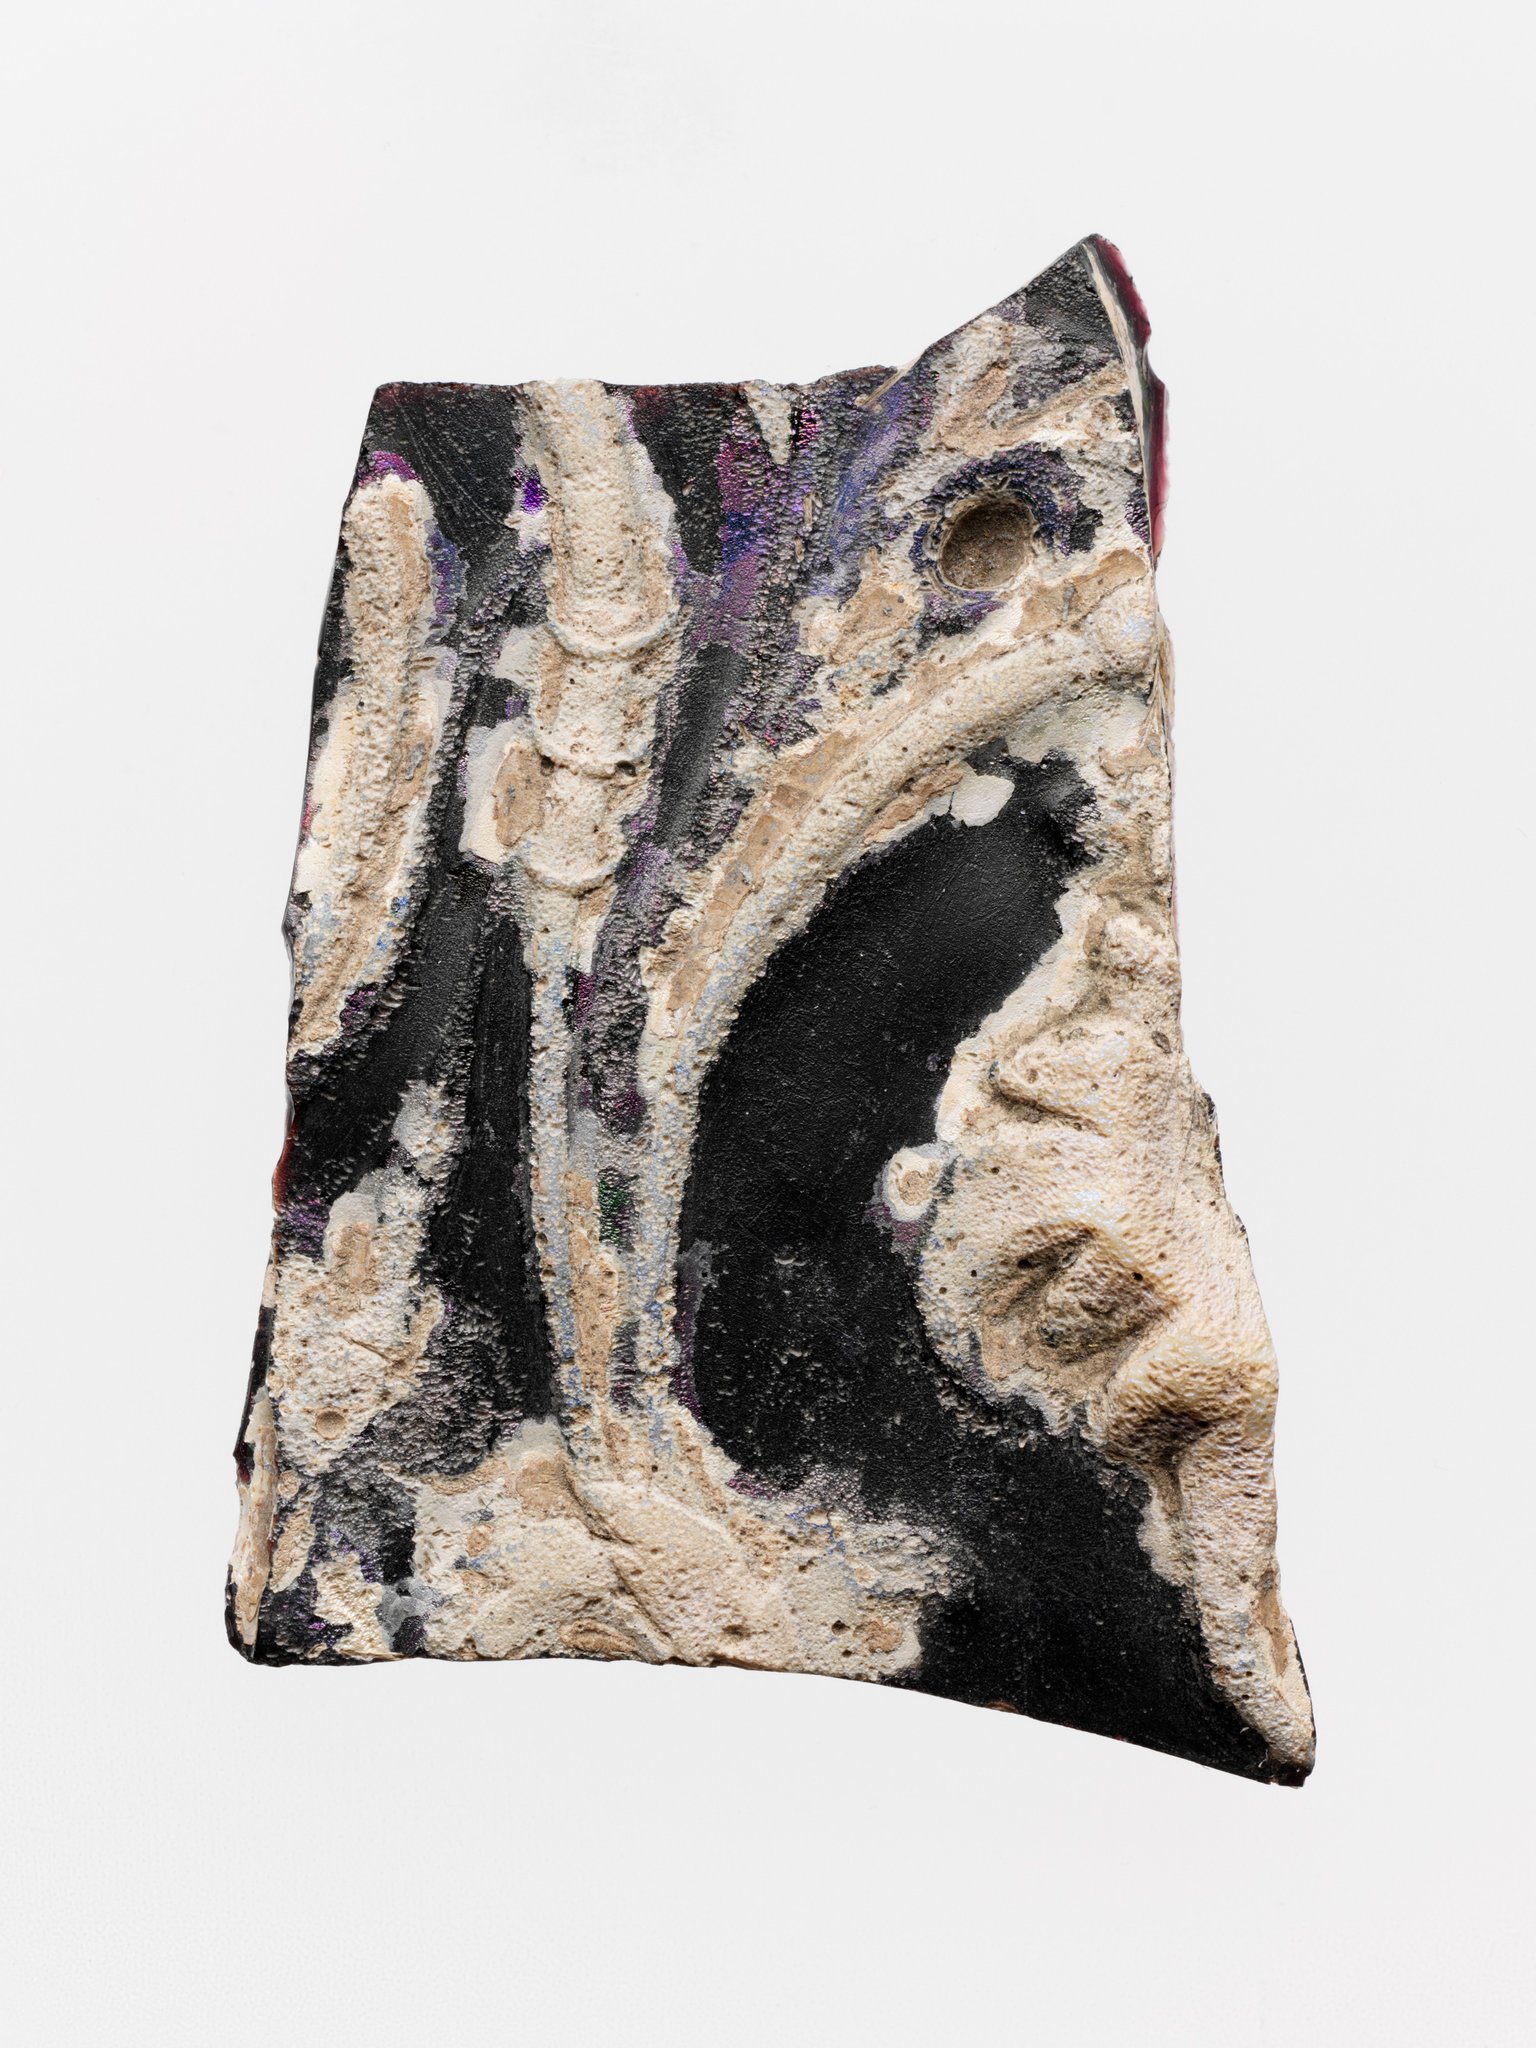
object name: cameo, fragment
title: Glass cameo panel fragment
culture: roman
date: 1-25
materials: glass